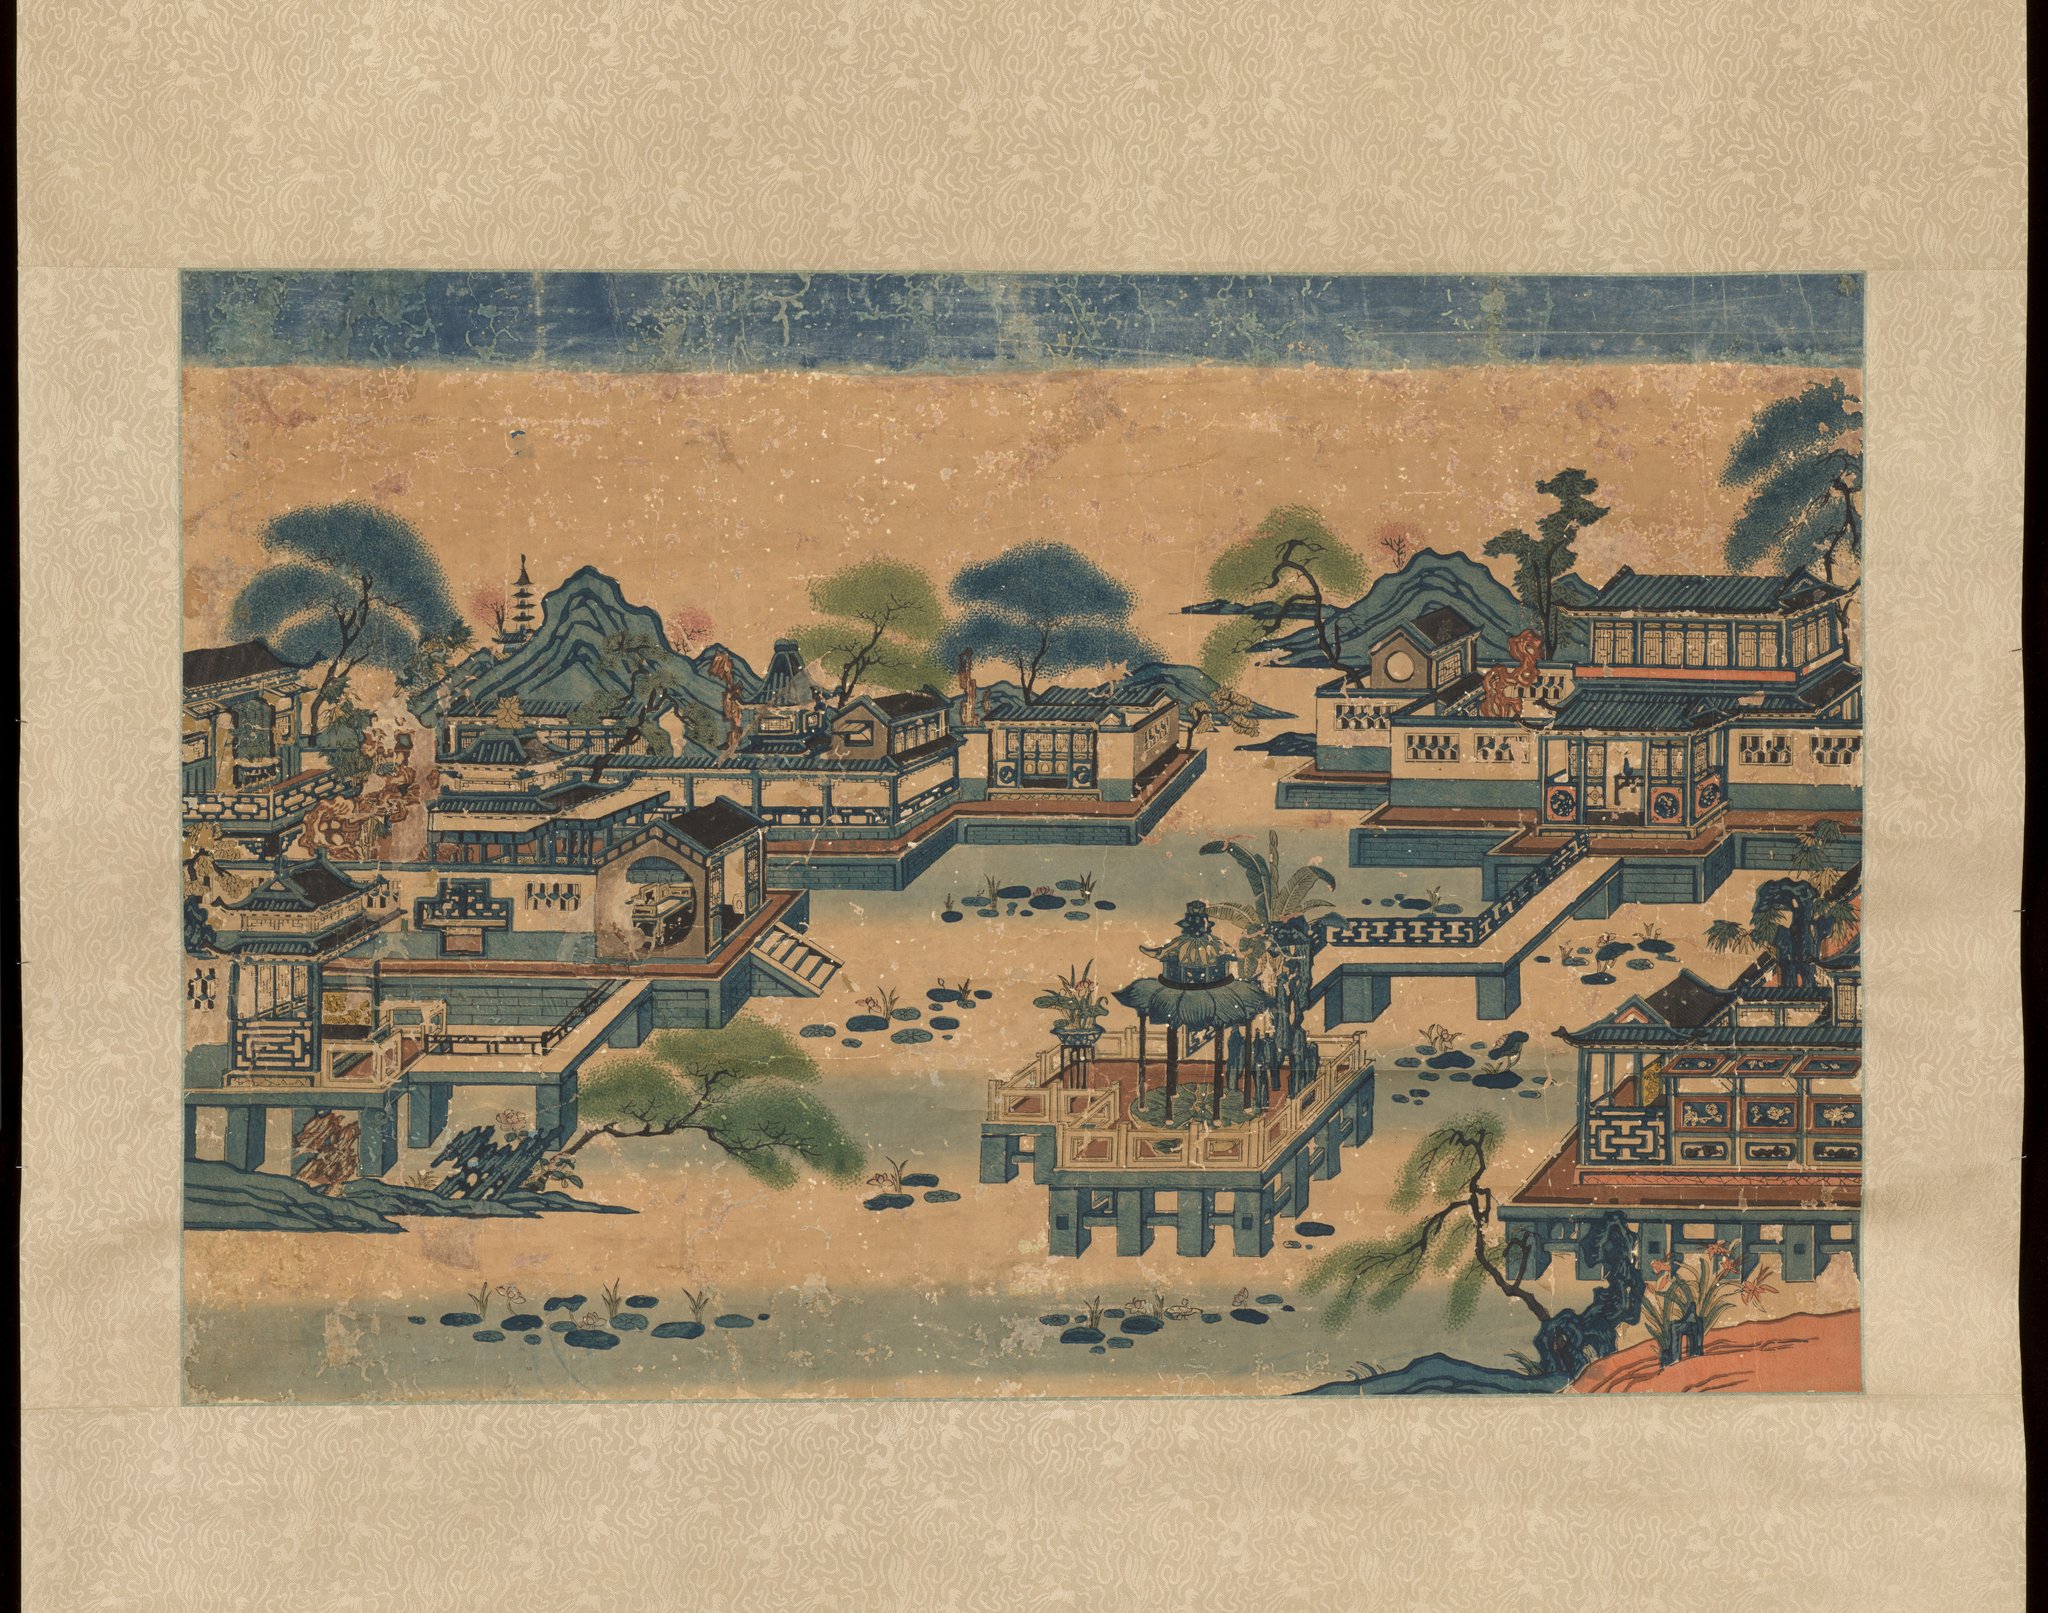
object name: print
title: Scenic Spots of Zhenjiang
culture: chinese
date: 1736-1795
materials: ink, paper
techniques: hand coloring, woodblock print